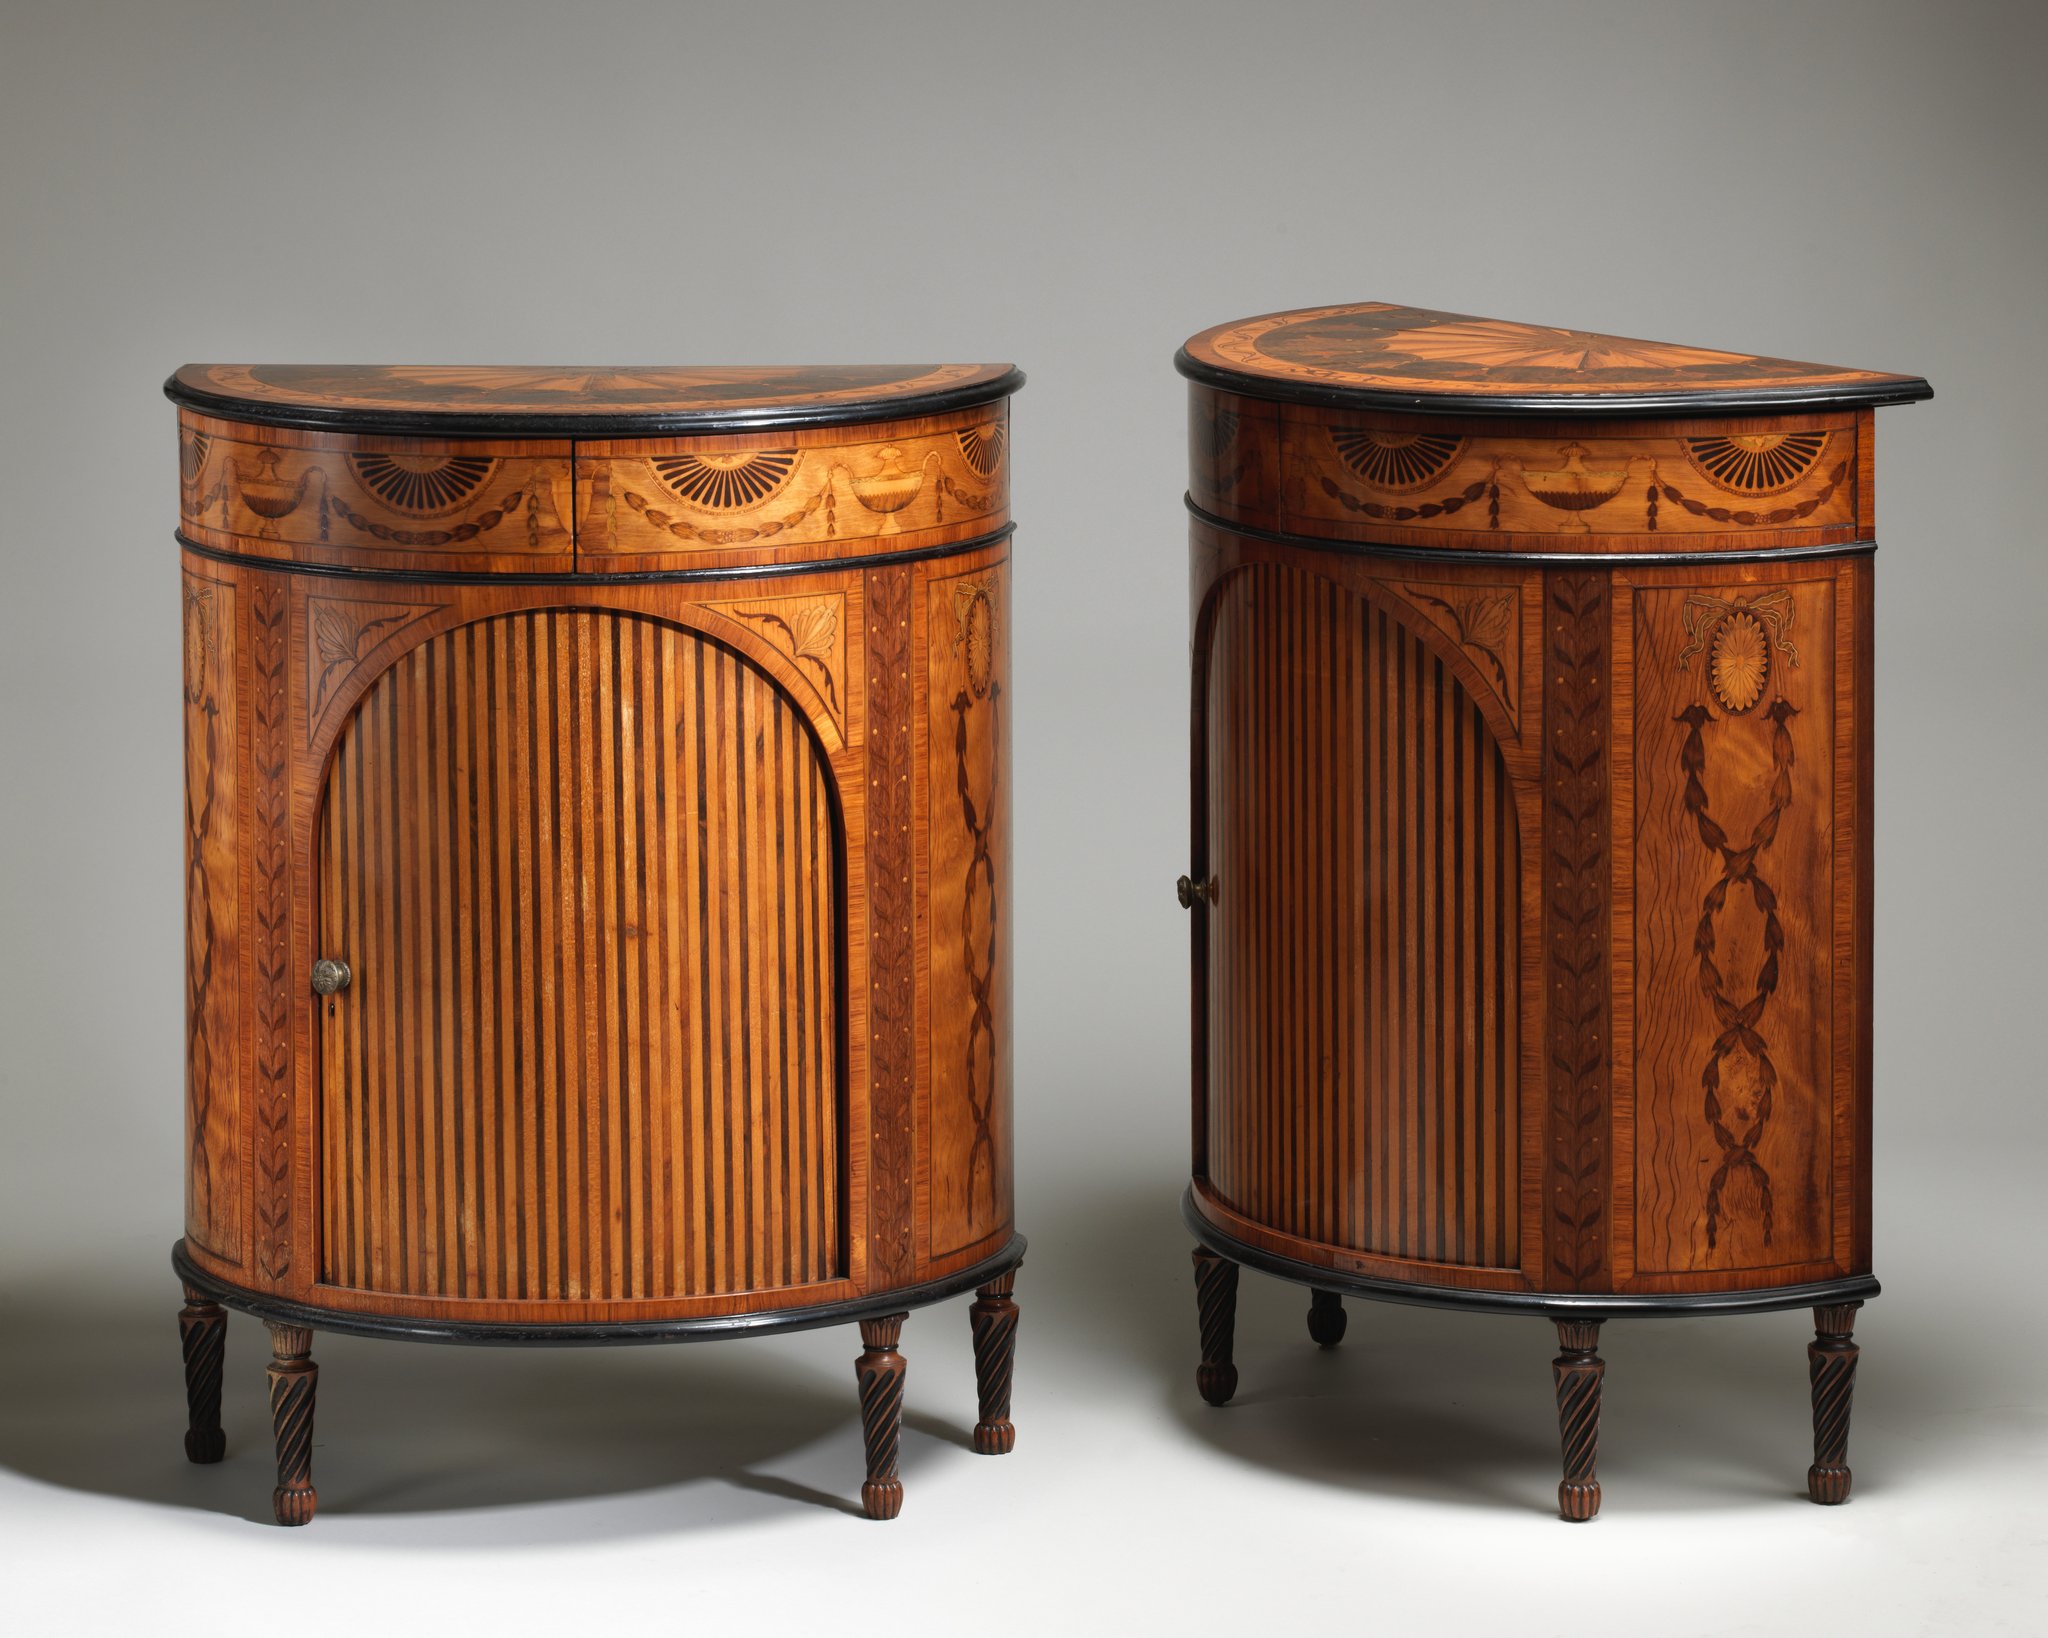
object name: demi lune cabinet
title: Pair of demi-lune cabinets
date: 1780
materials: wood